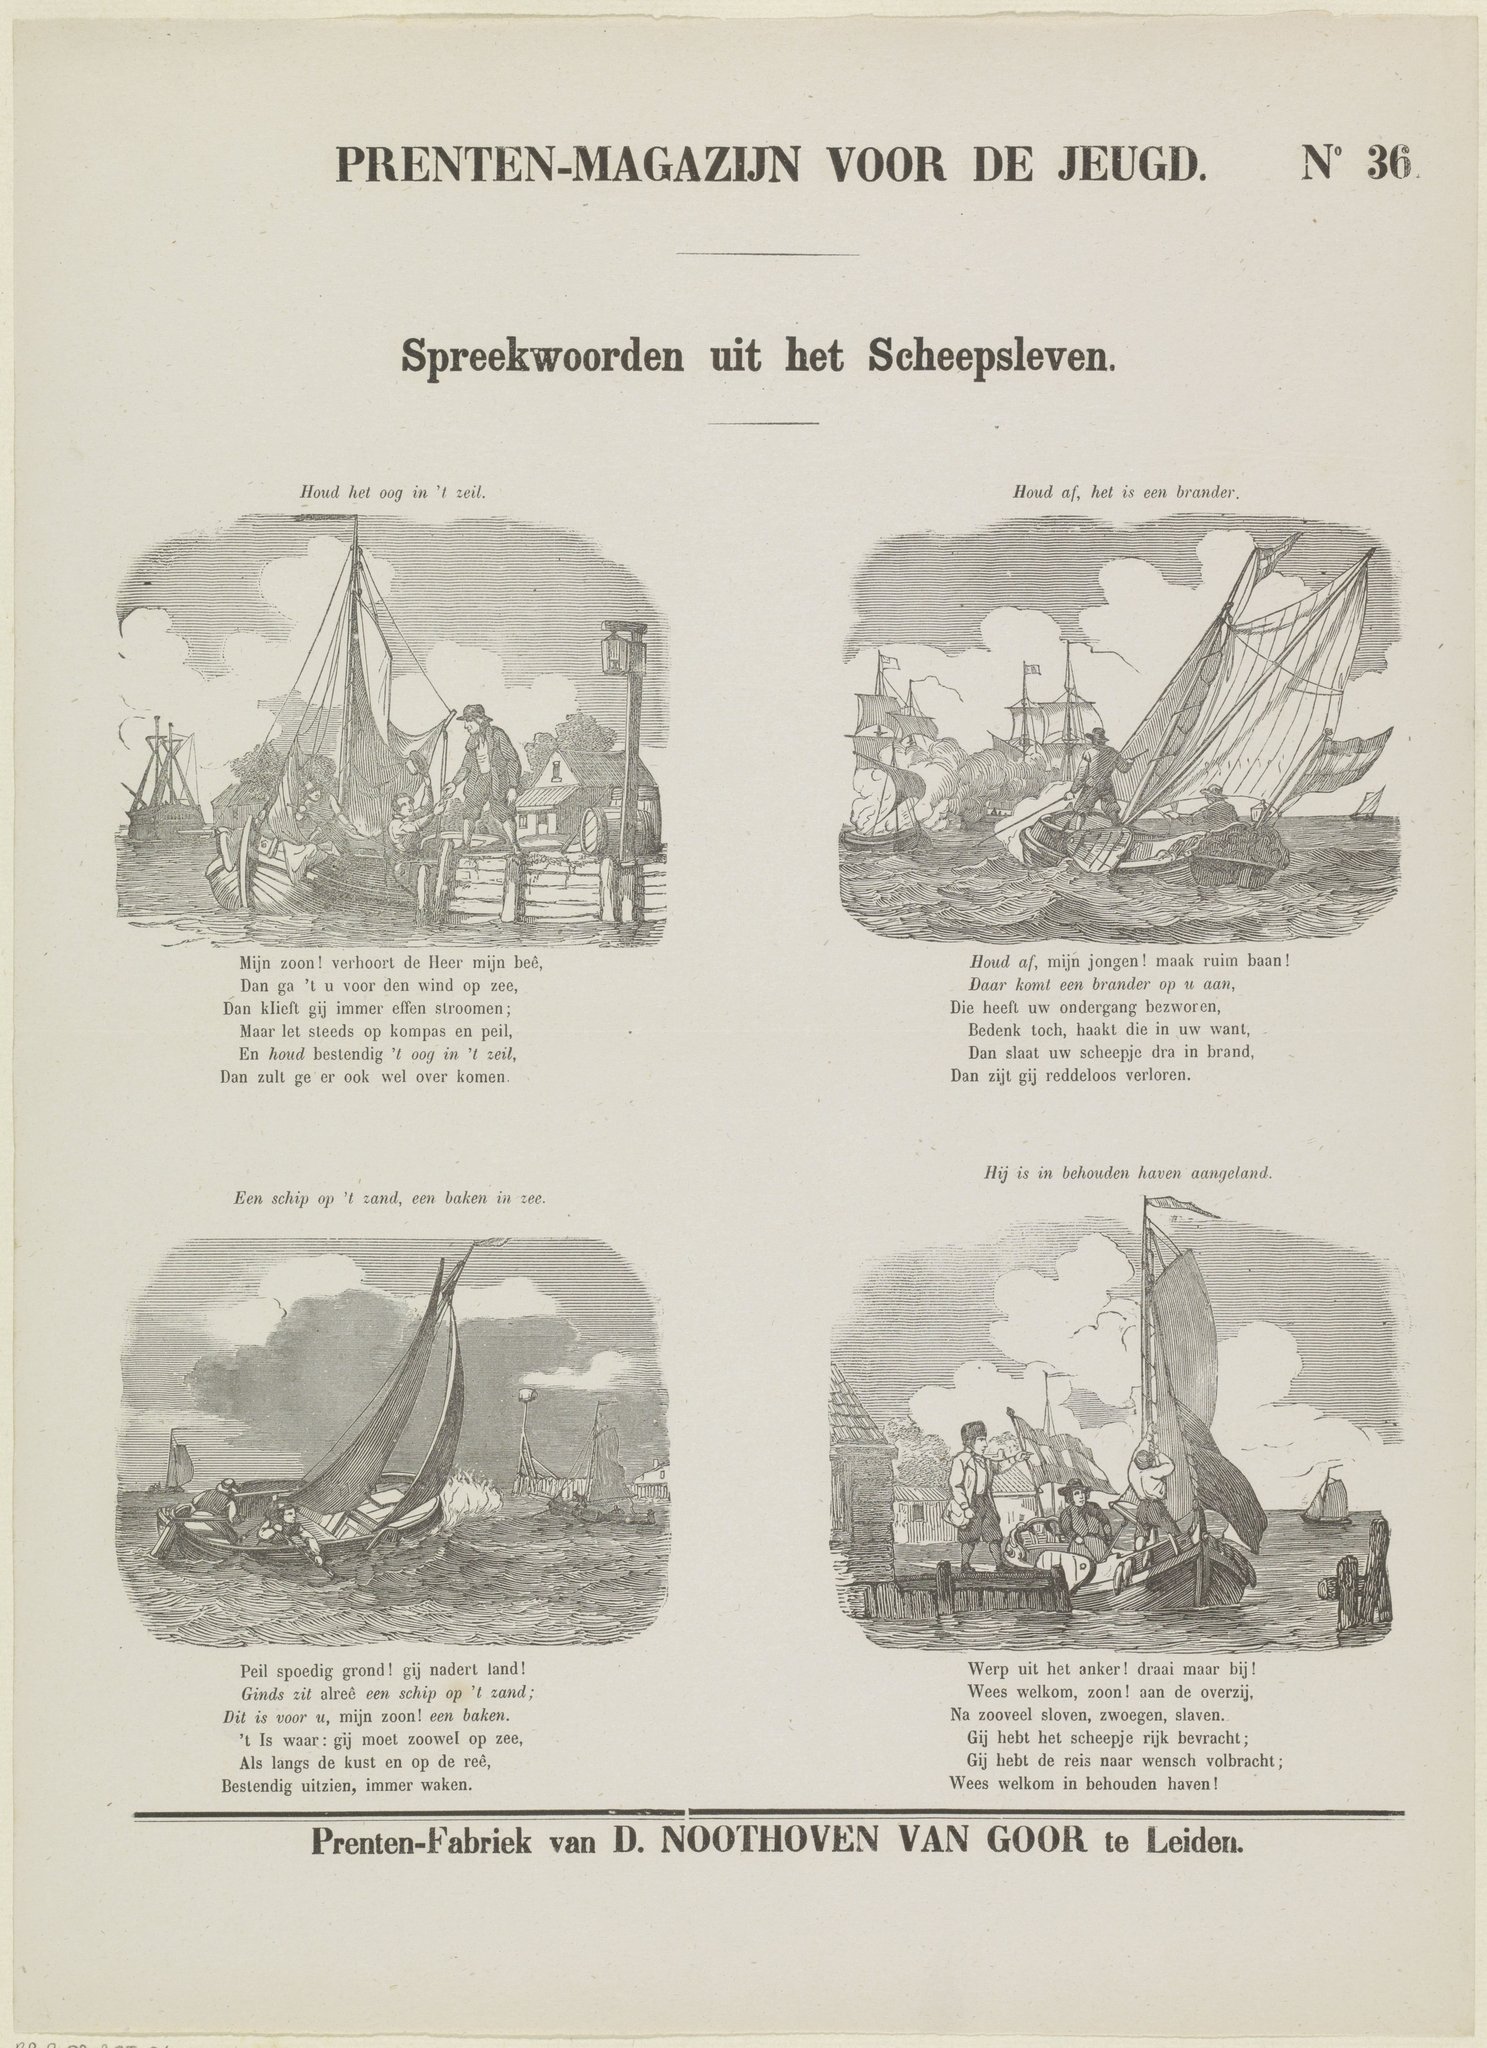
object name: popular print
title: Spreekwoorden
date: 1850-1881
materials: paper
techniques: letterpress printing, engraving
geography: leiden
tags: ships (in general), proverbs, sayings, etc., seaman: sailor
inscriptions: collector's mark: Lugt 2760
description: Blad met 4 verbeeldingen van spreekwoorden uit het scheepsleven. Boven elke voorstelling een titel en onder elke voorstelling een zesregelig vers. Genummerd rechtsboven: No. 36.